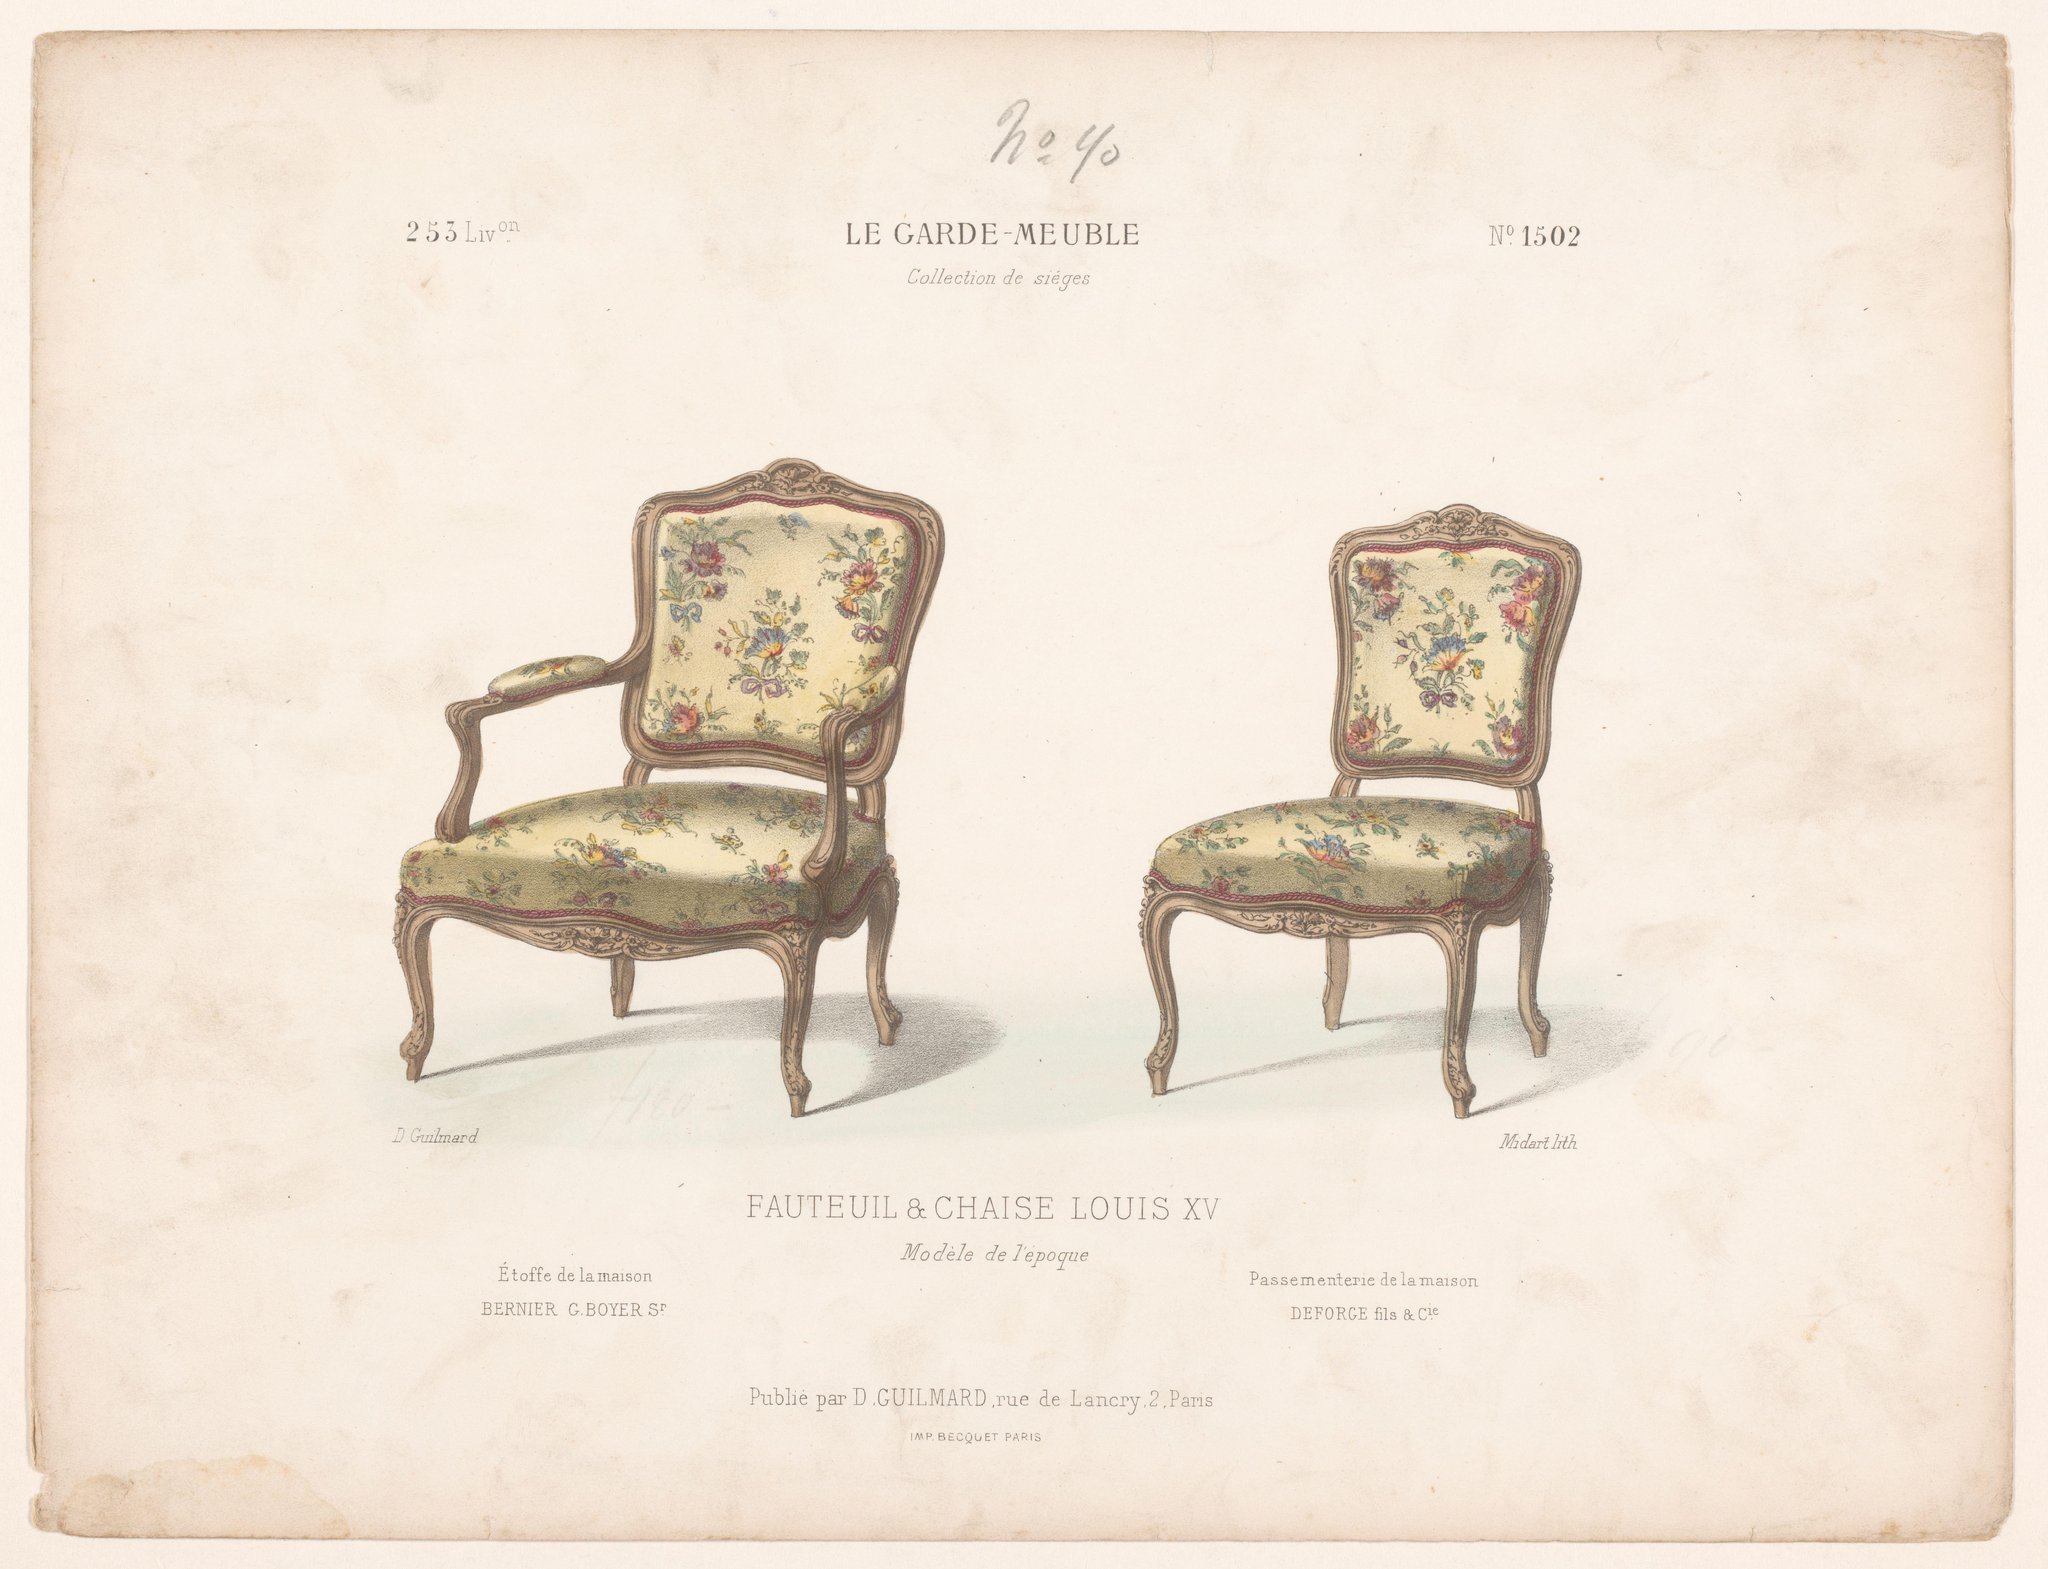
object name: print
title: Le garde-meuble / Collection de Sièges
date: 1839-1885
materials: paper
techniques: hand coloring, lithograph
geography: paris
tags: seating furniture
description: Ieder Livraison in de serie Le Garde-Meuble bevat negen platen: drie 'sièges' (zitmeubels), drie 'meubles' (diverse meubels zoals tafels en kasten) en drie 'tentures' (gordijnen en draperieën).